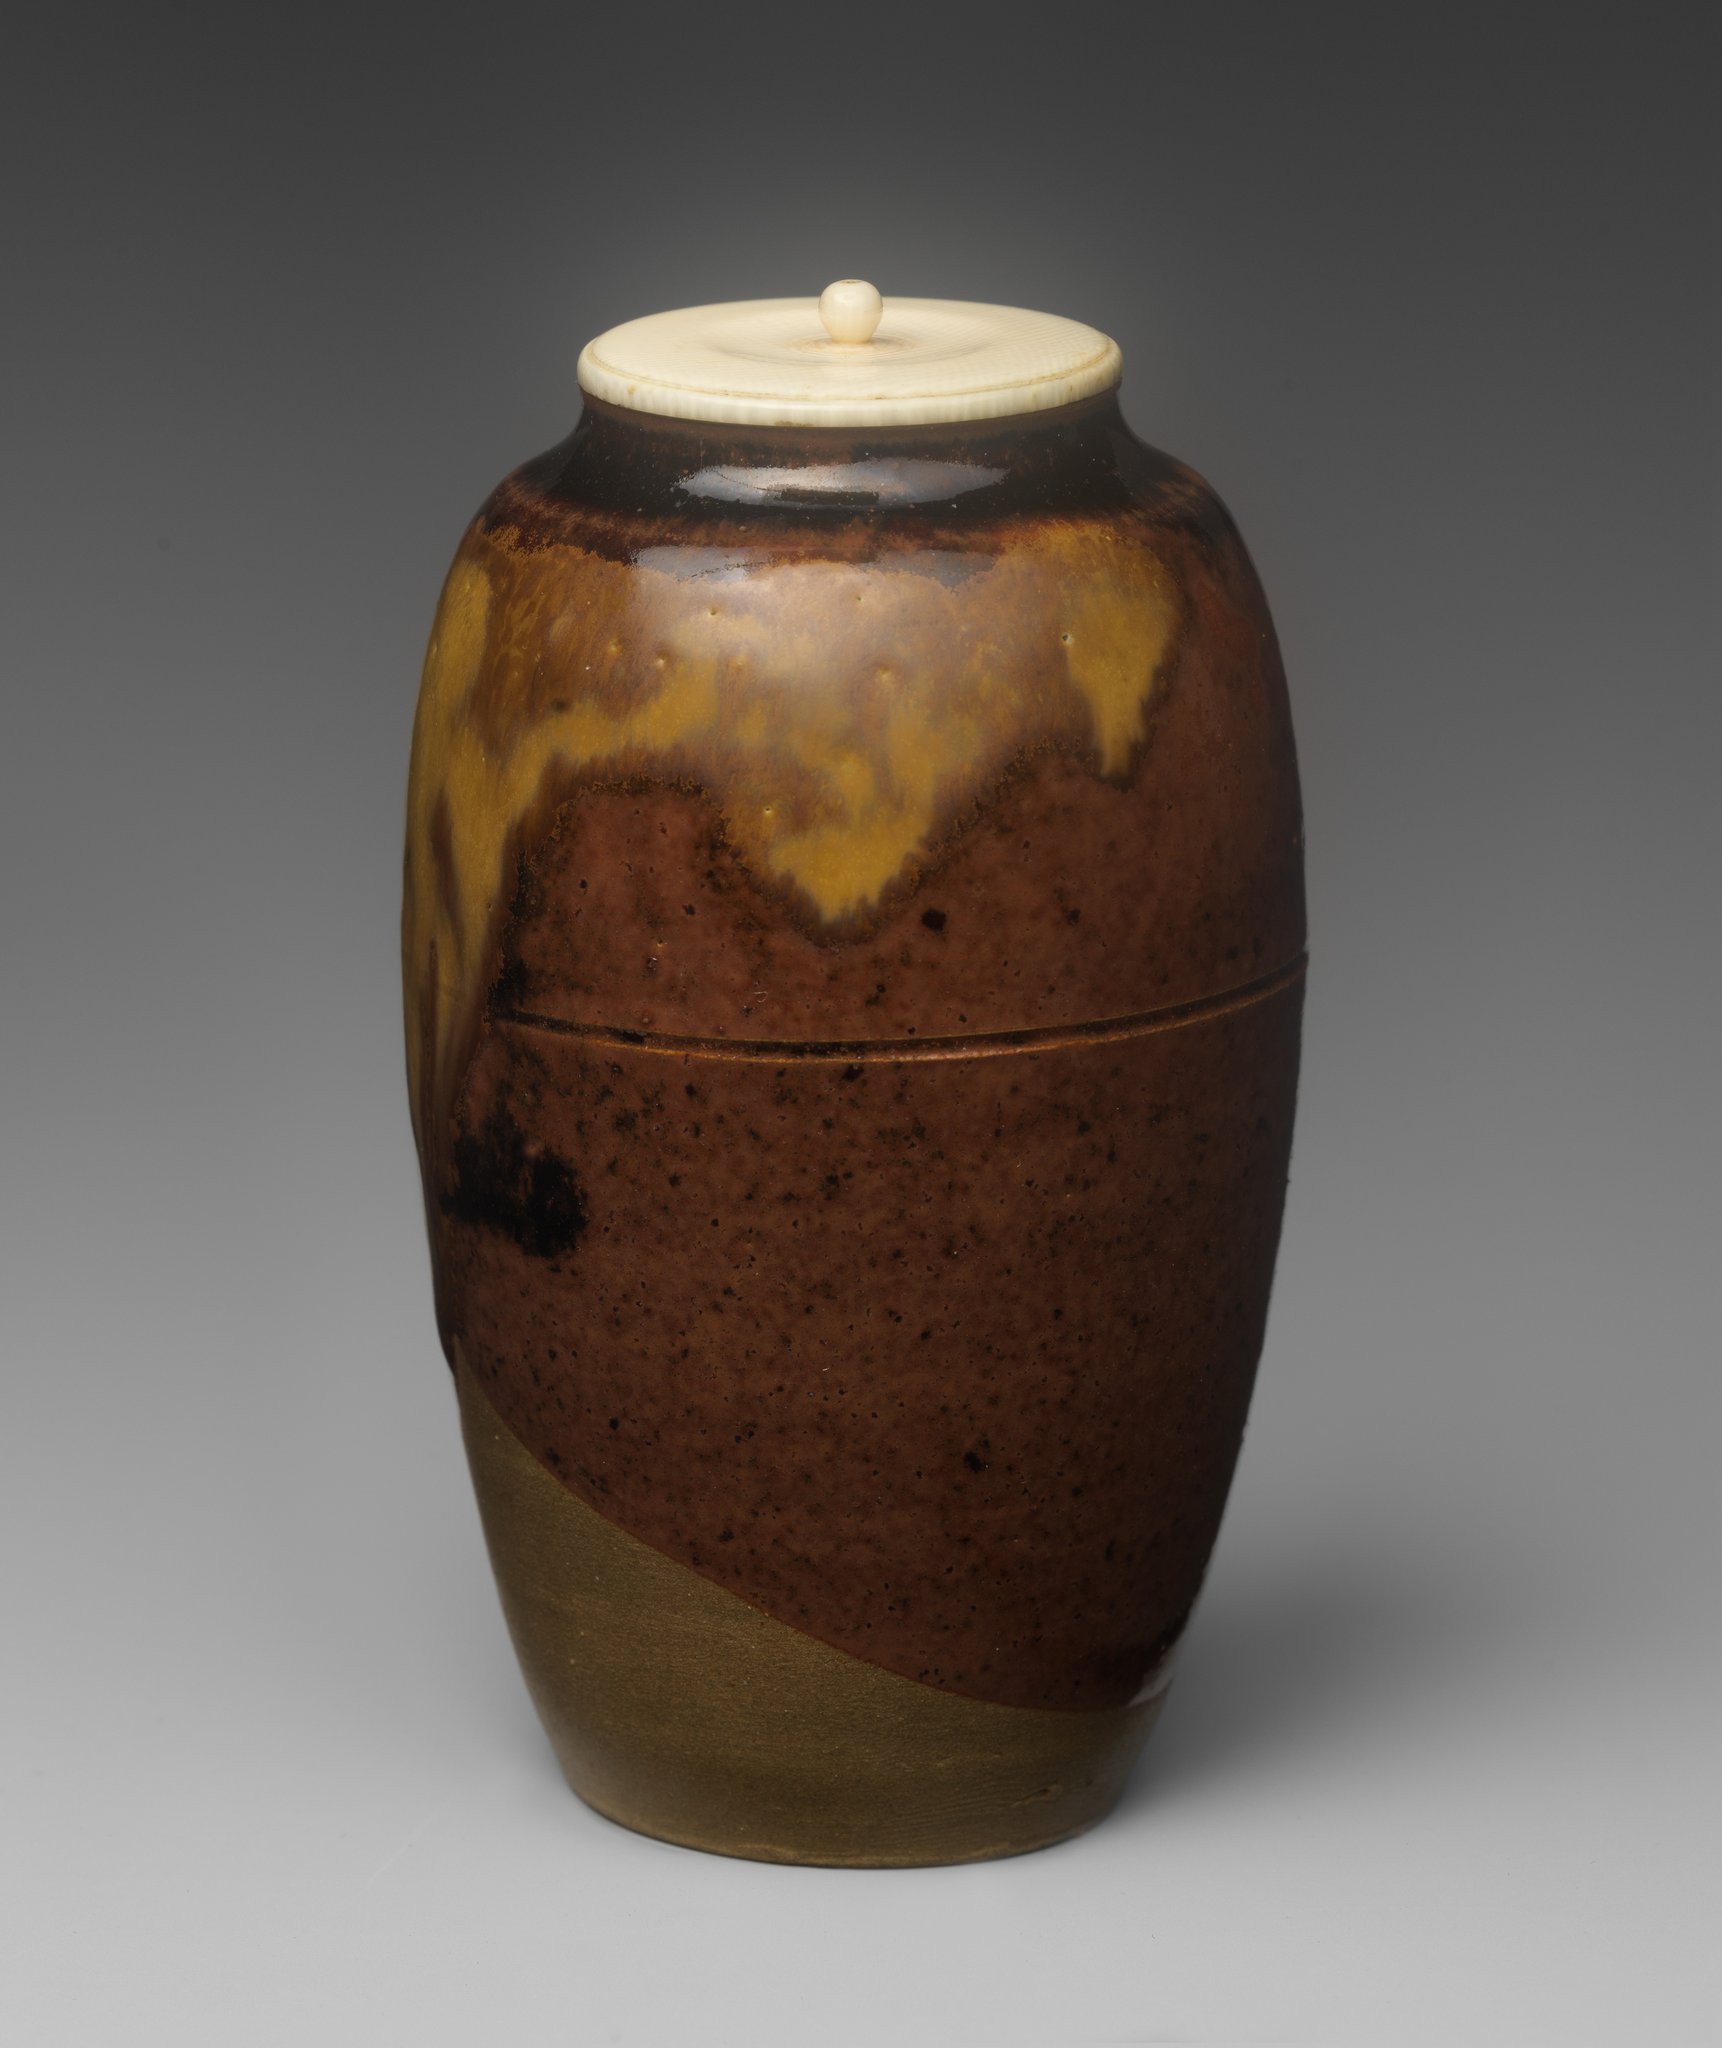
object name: tea caddy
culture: japanese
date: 1701-1800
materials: glaze, iron, stoneware